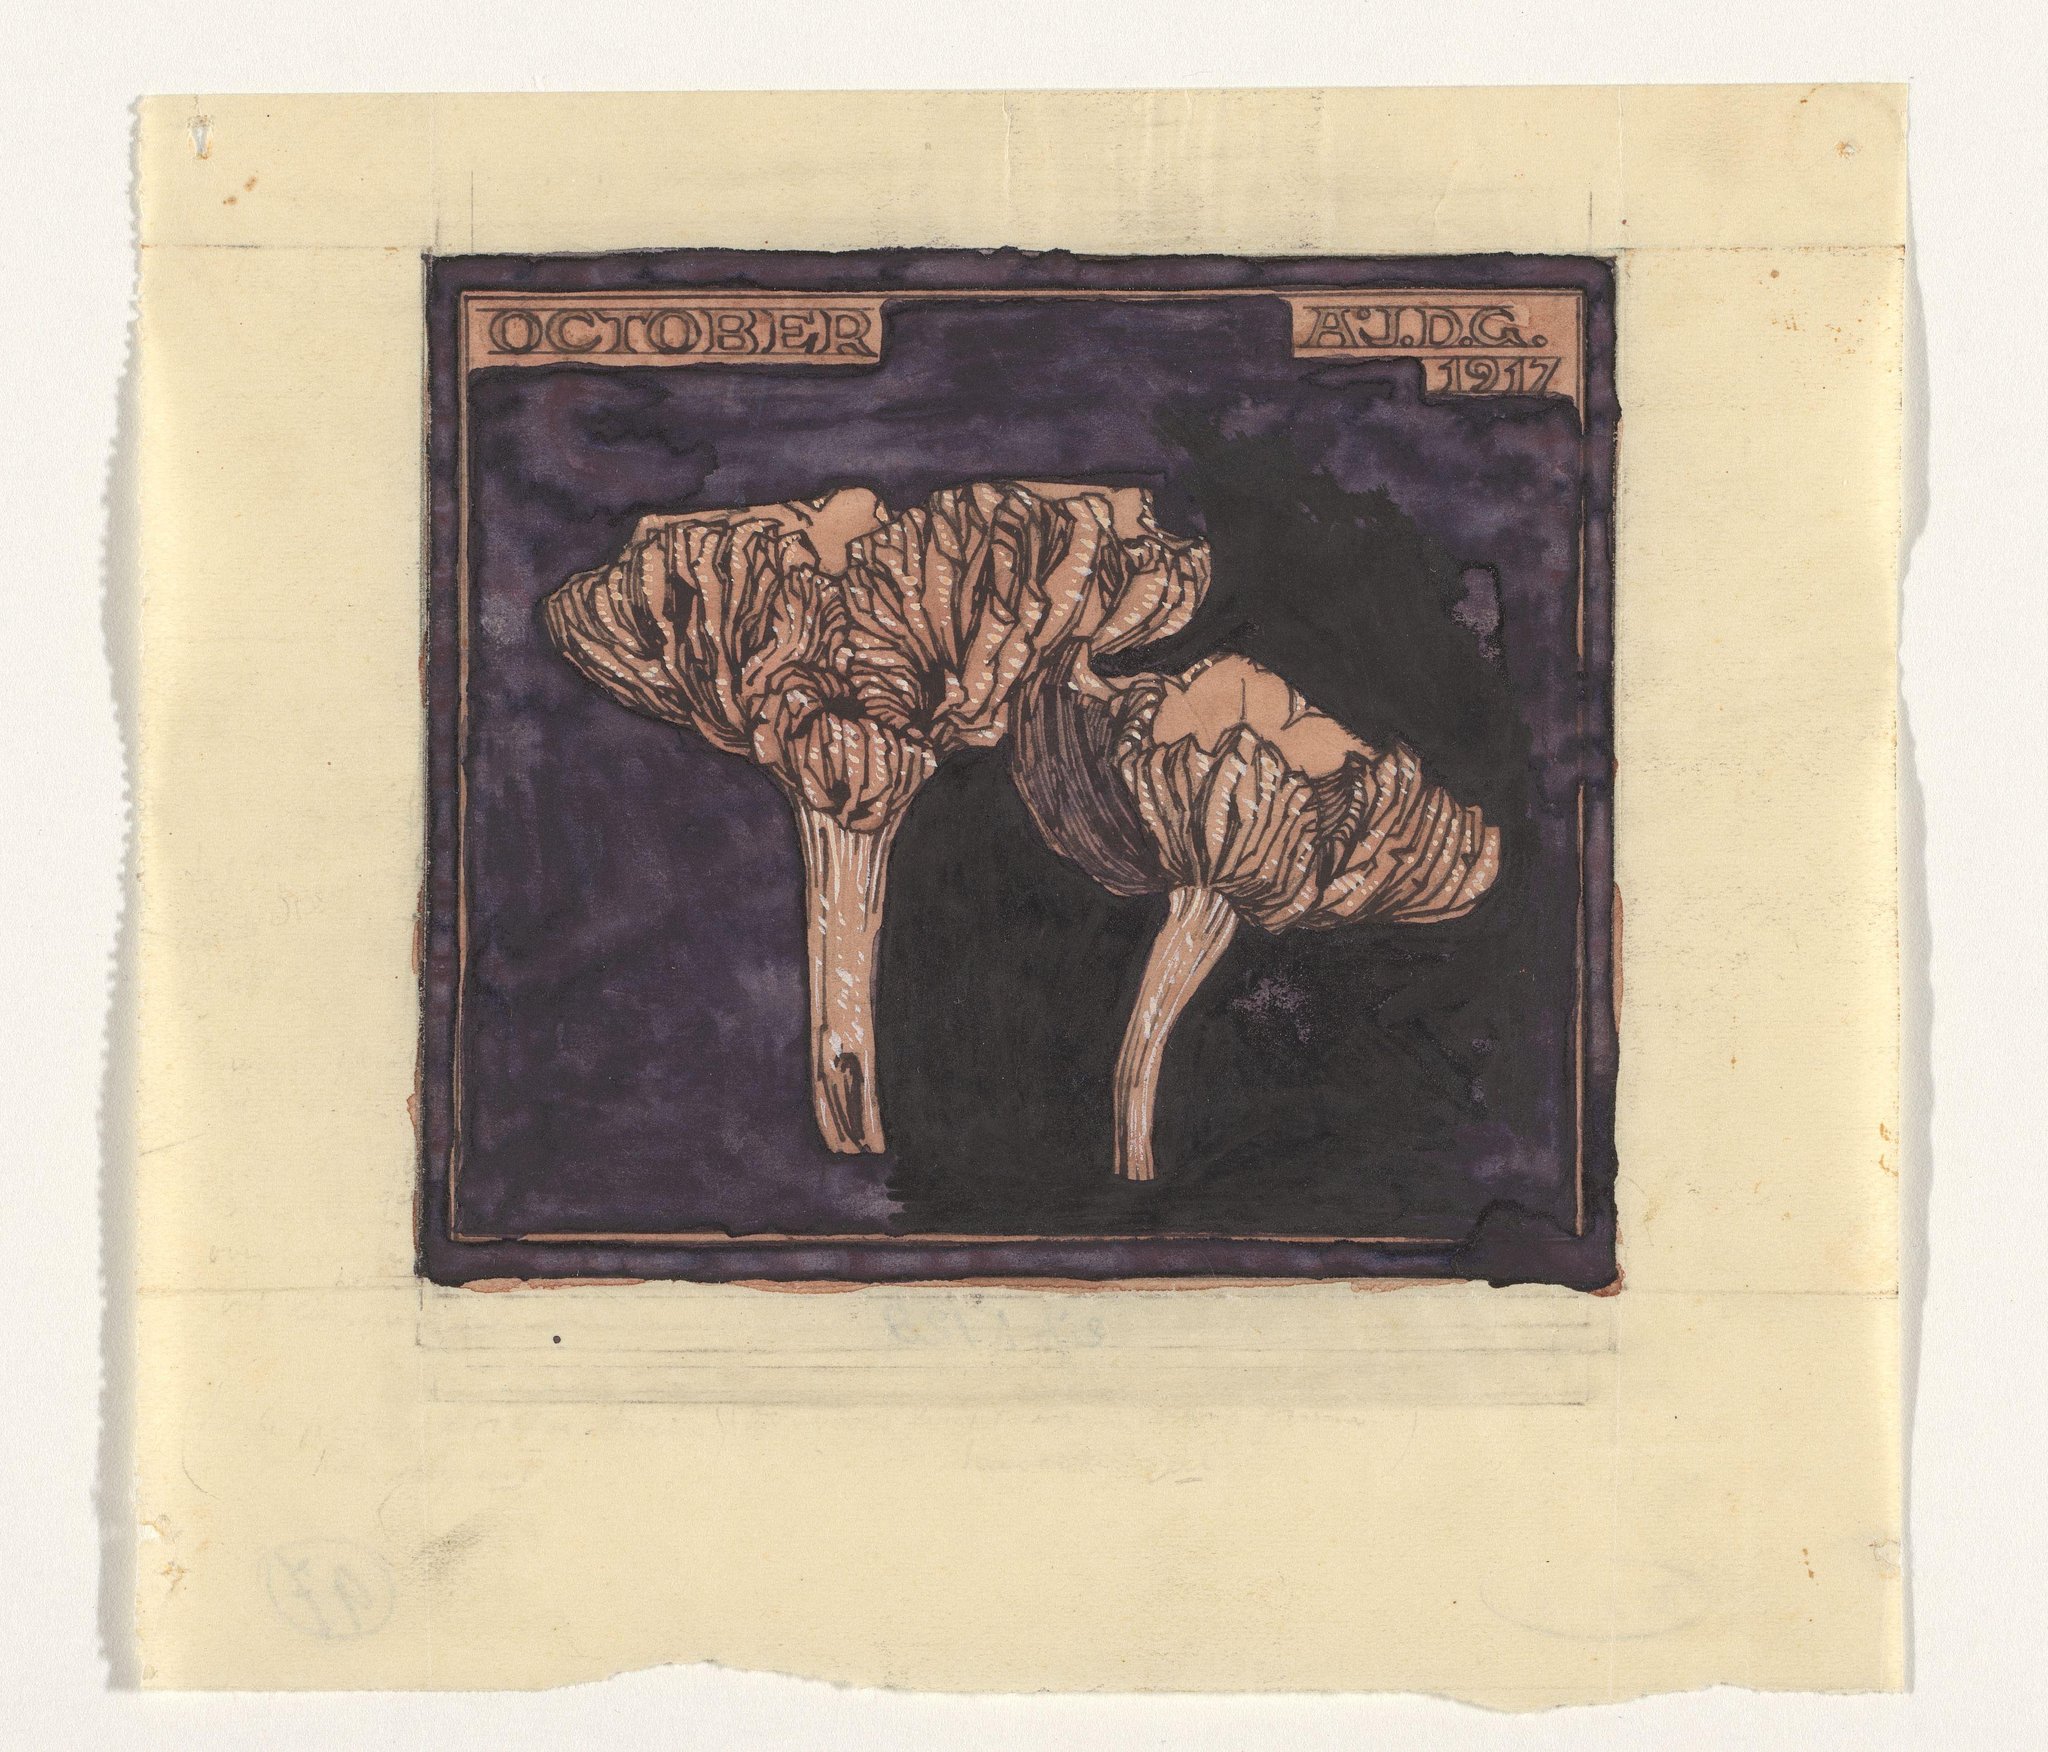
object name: drawing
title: October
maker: julie de graag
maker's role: draughtsman, print maker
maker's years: 1877-1924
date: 1917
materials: paint, ink, paper, pencil, watercolor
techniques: brush, pen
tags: mushrooms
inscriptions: number: ‘97’